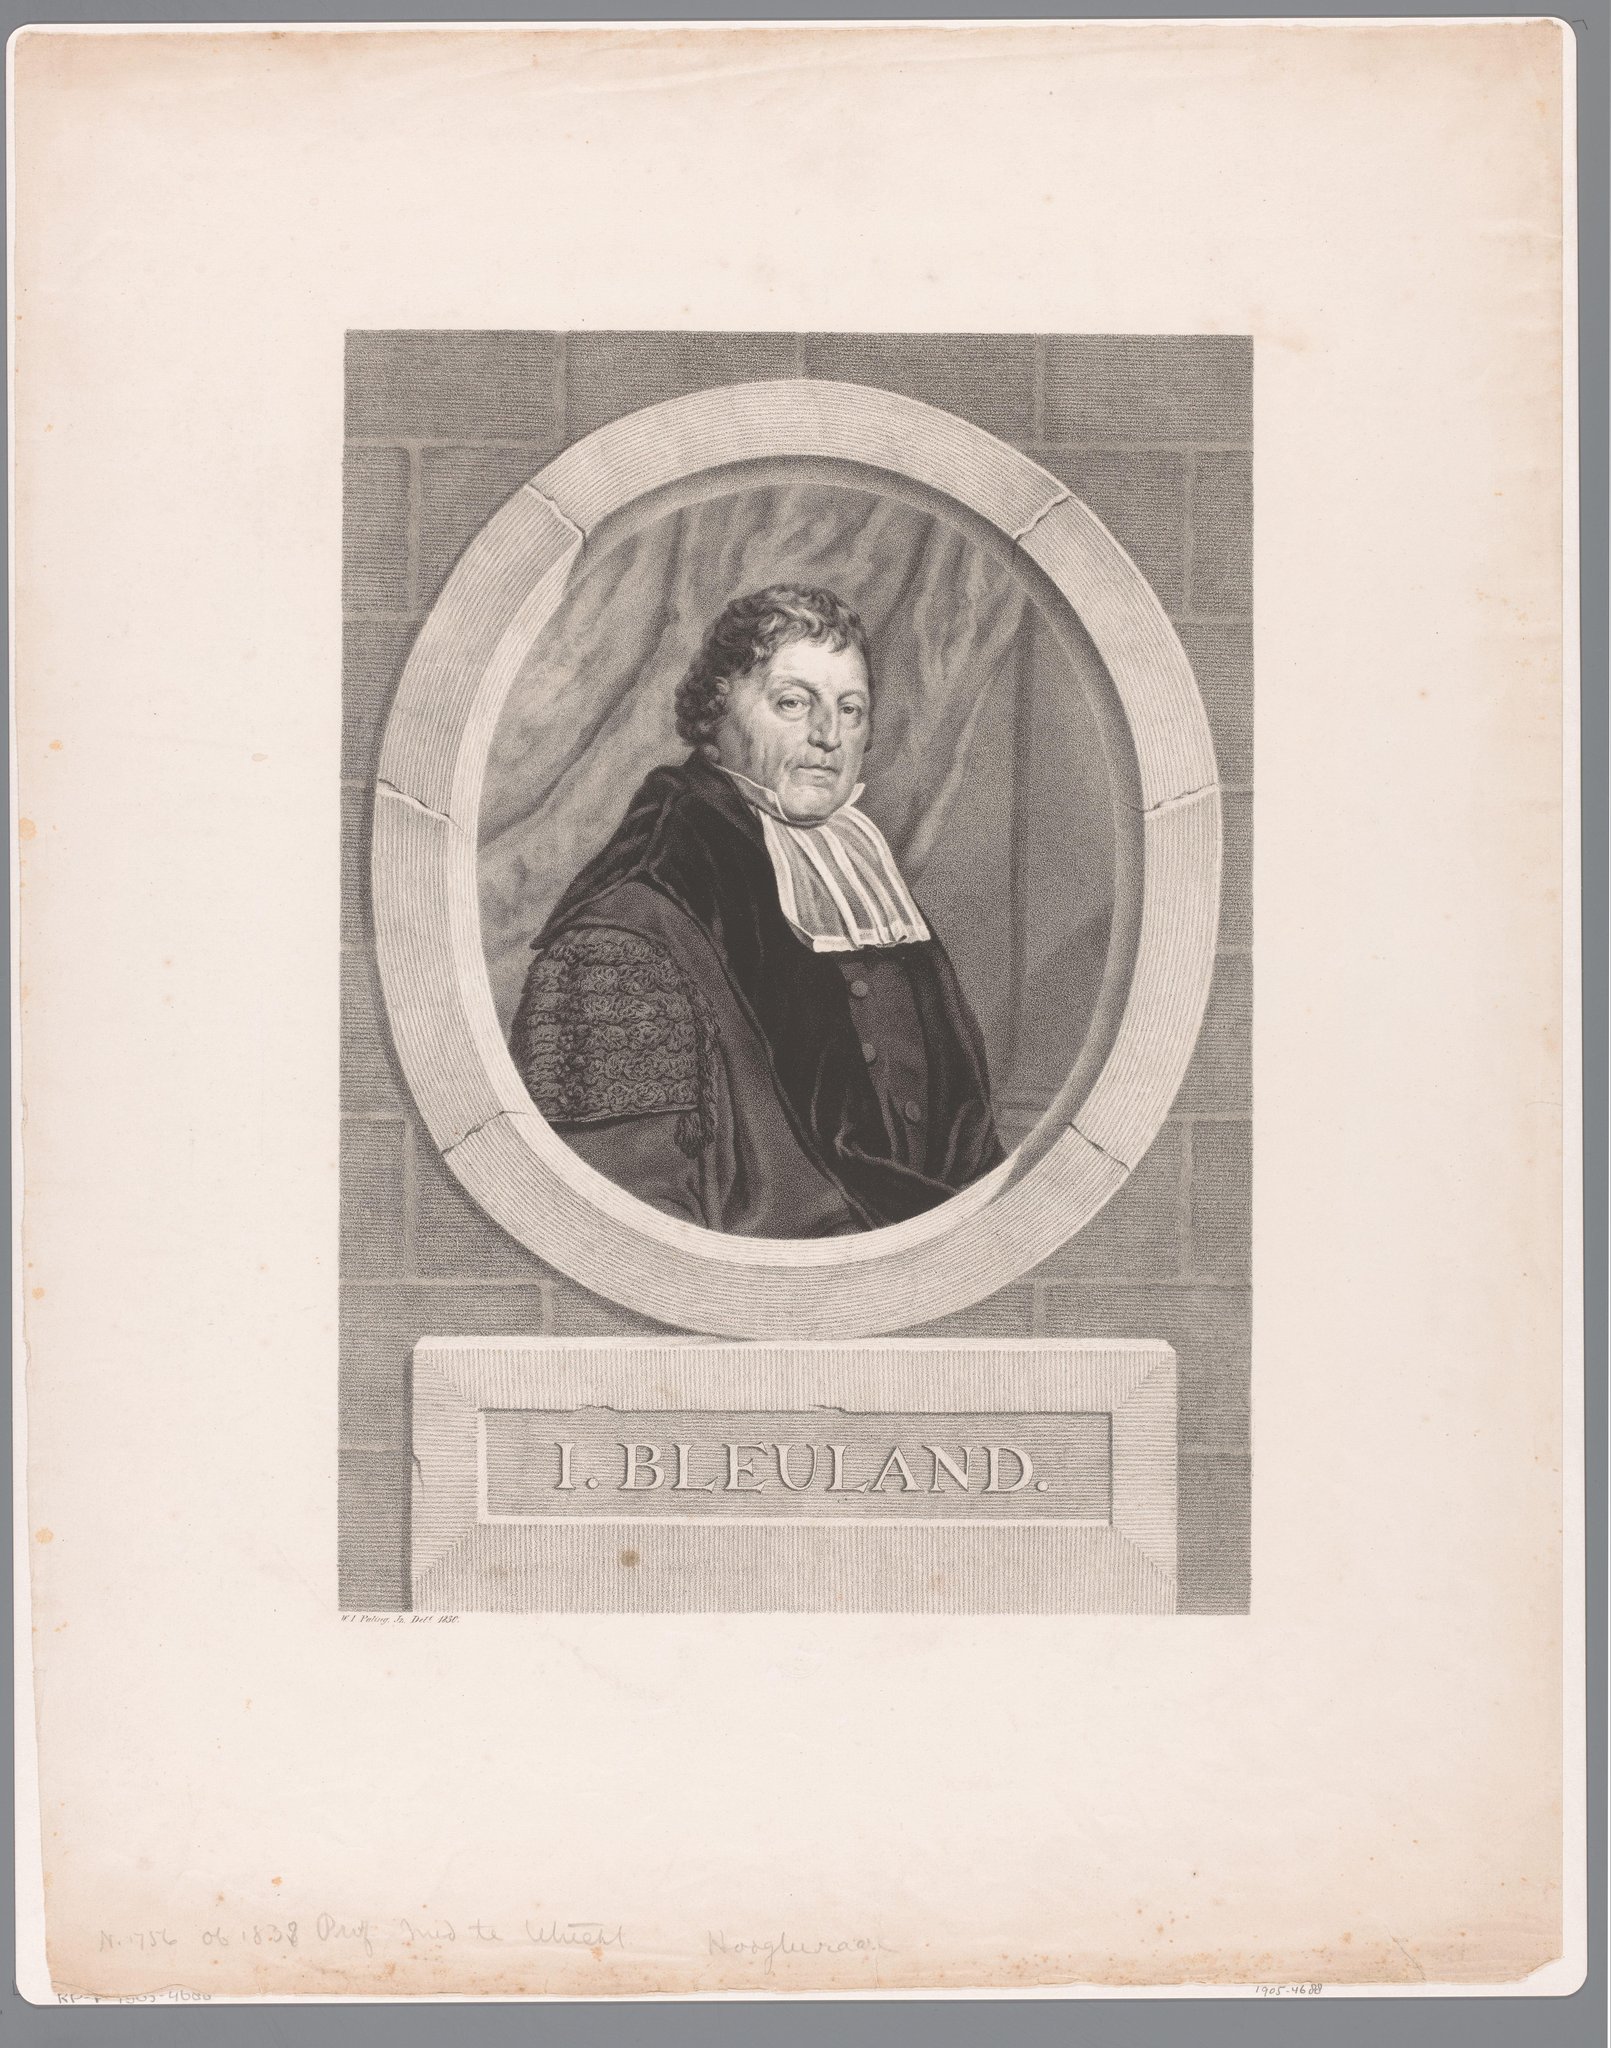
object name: print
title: Portret van Jan Bleuland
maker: willem jan paling jz.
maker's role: print maker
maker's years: 1776-1848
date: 1830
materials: paper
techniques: lithograph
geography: netherlands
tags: gouda, utrecht, jan bleuland, historical persons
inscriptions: check stamp, collector's mark: Lugt 2228